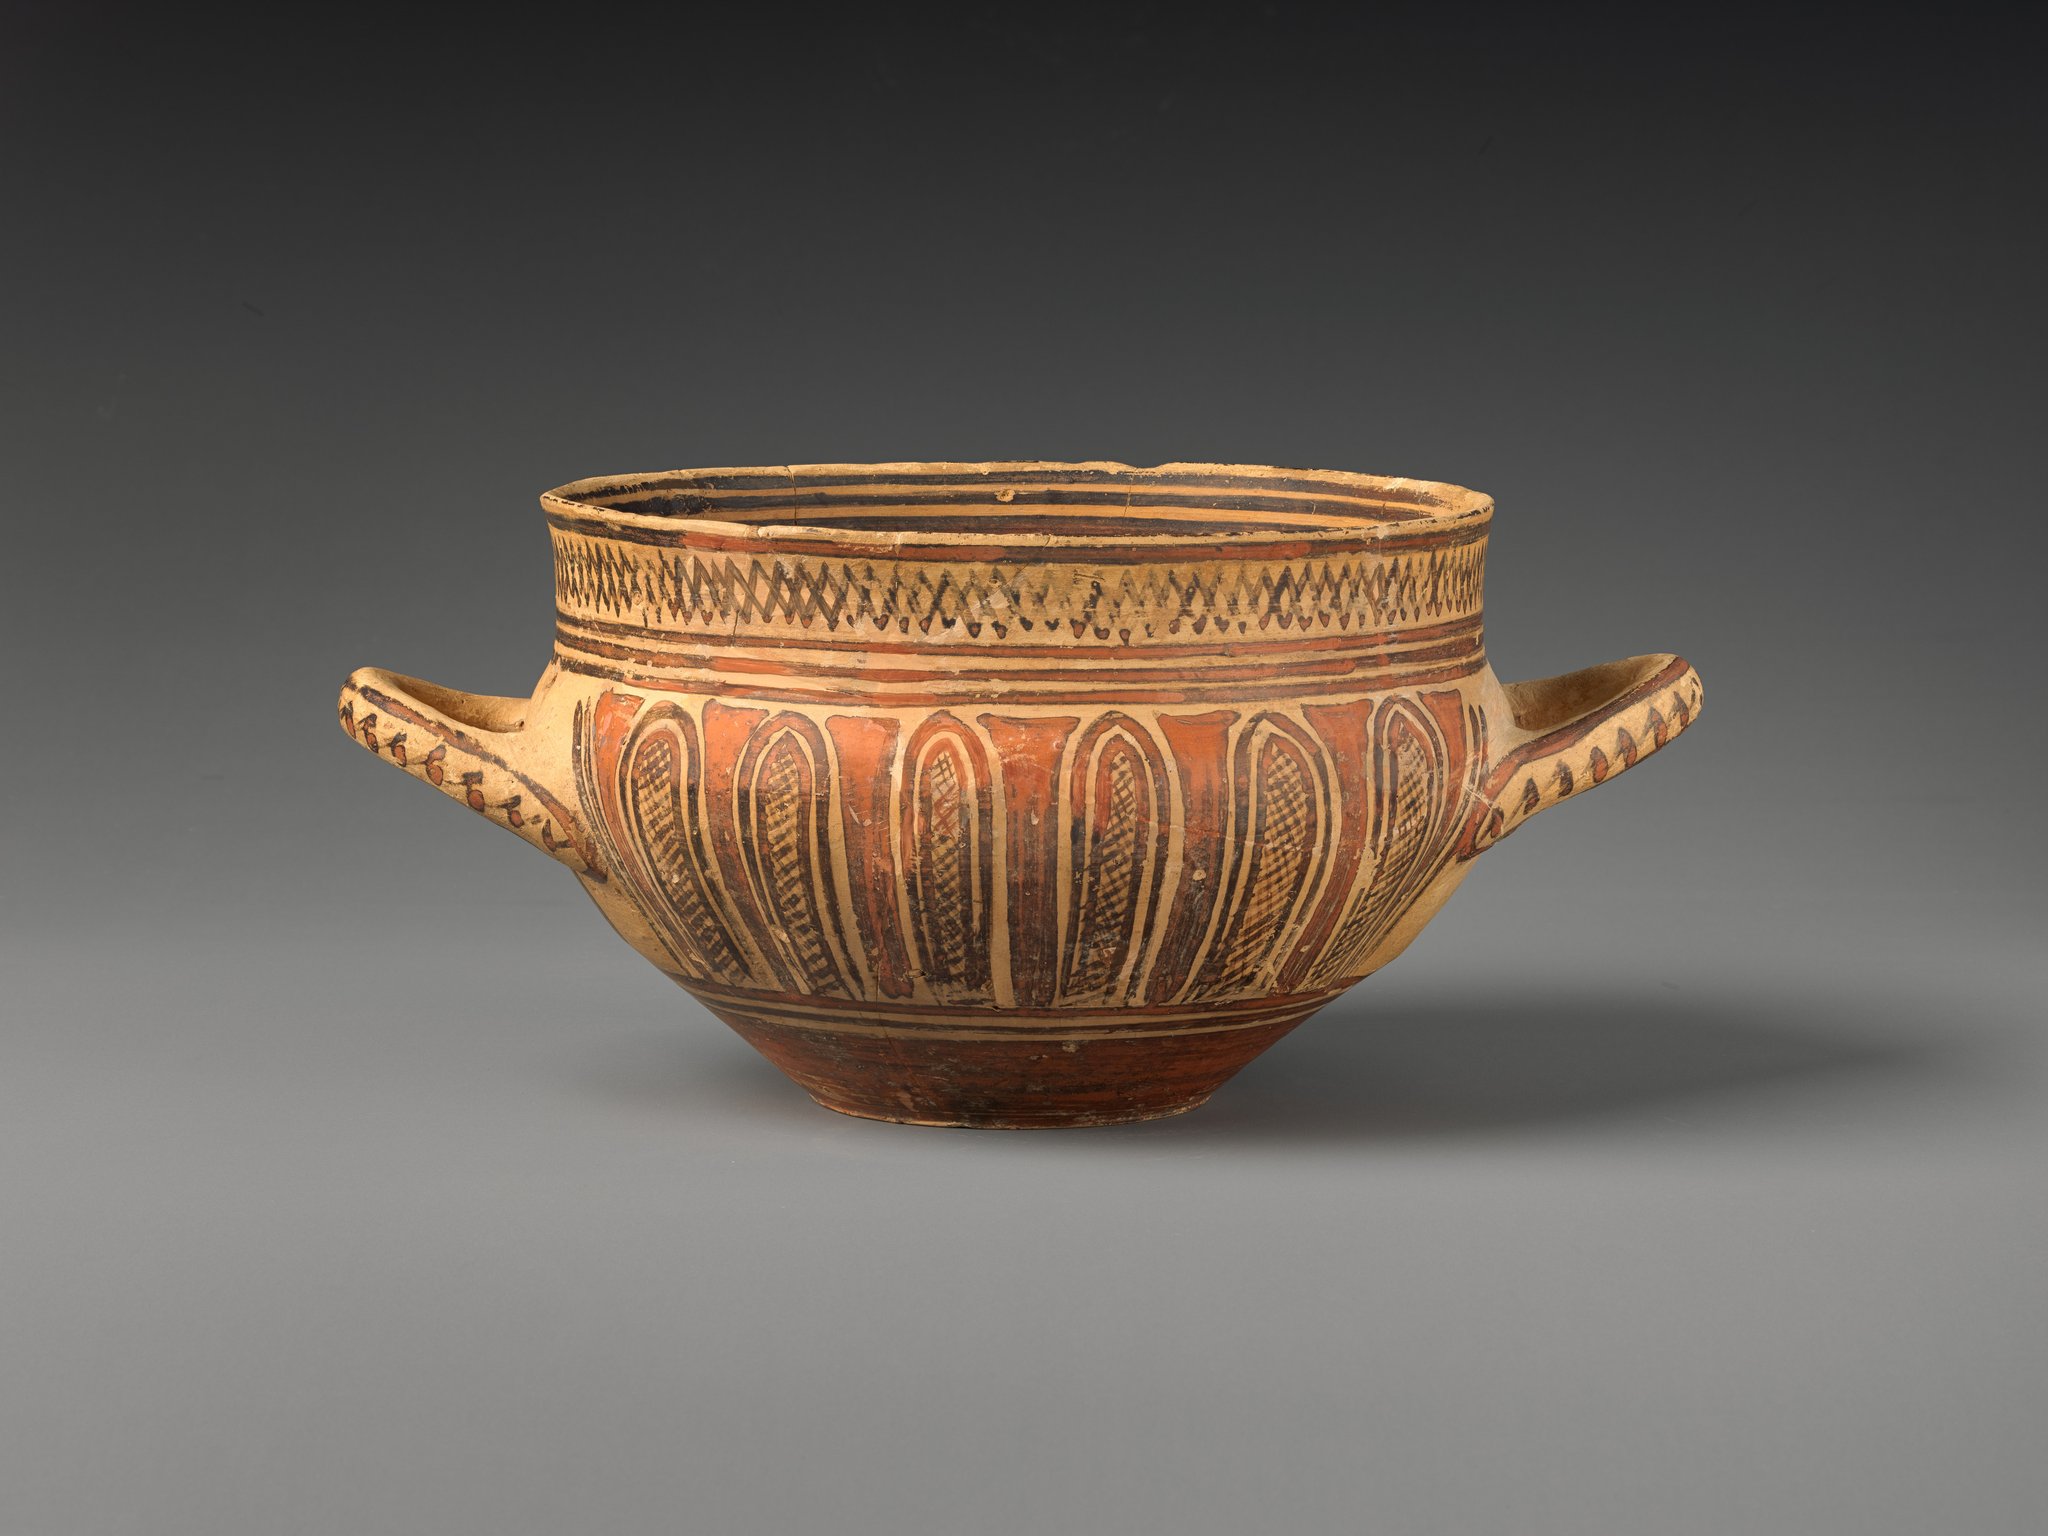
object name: skyphos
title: Terracotta skyphos (drinking cup with two handles)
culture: greek, attic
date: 750-735 BCE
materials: terracotta